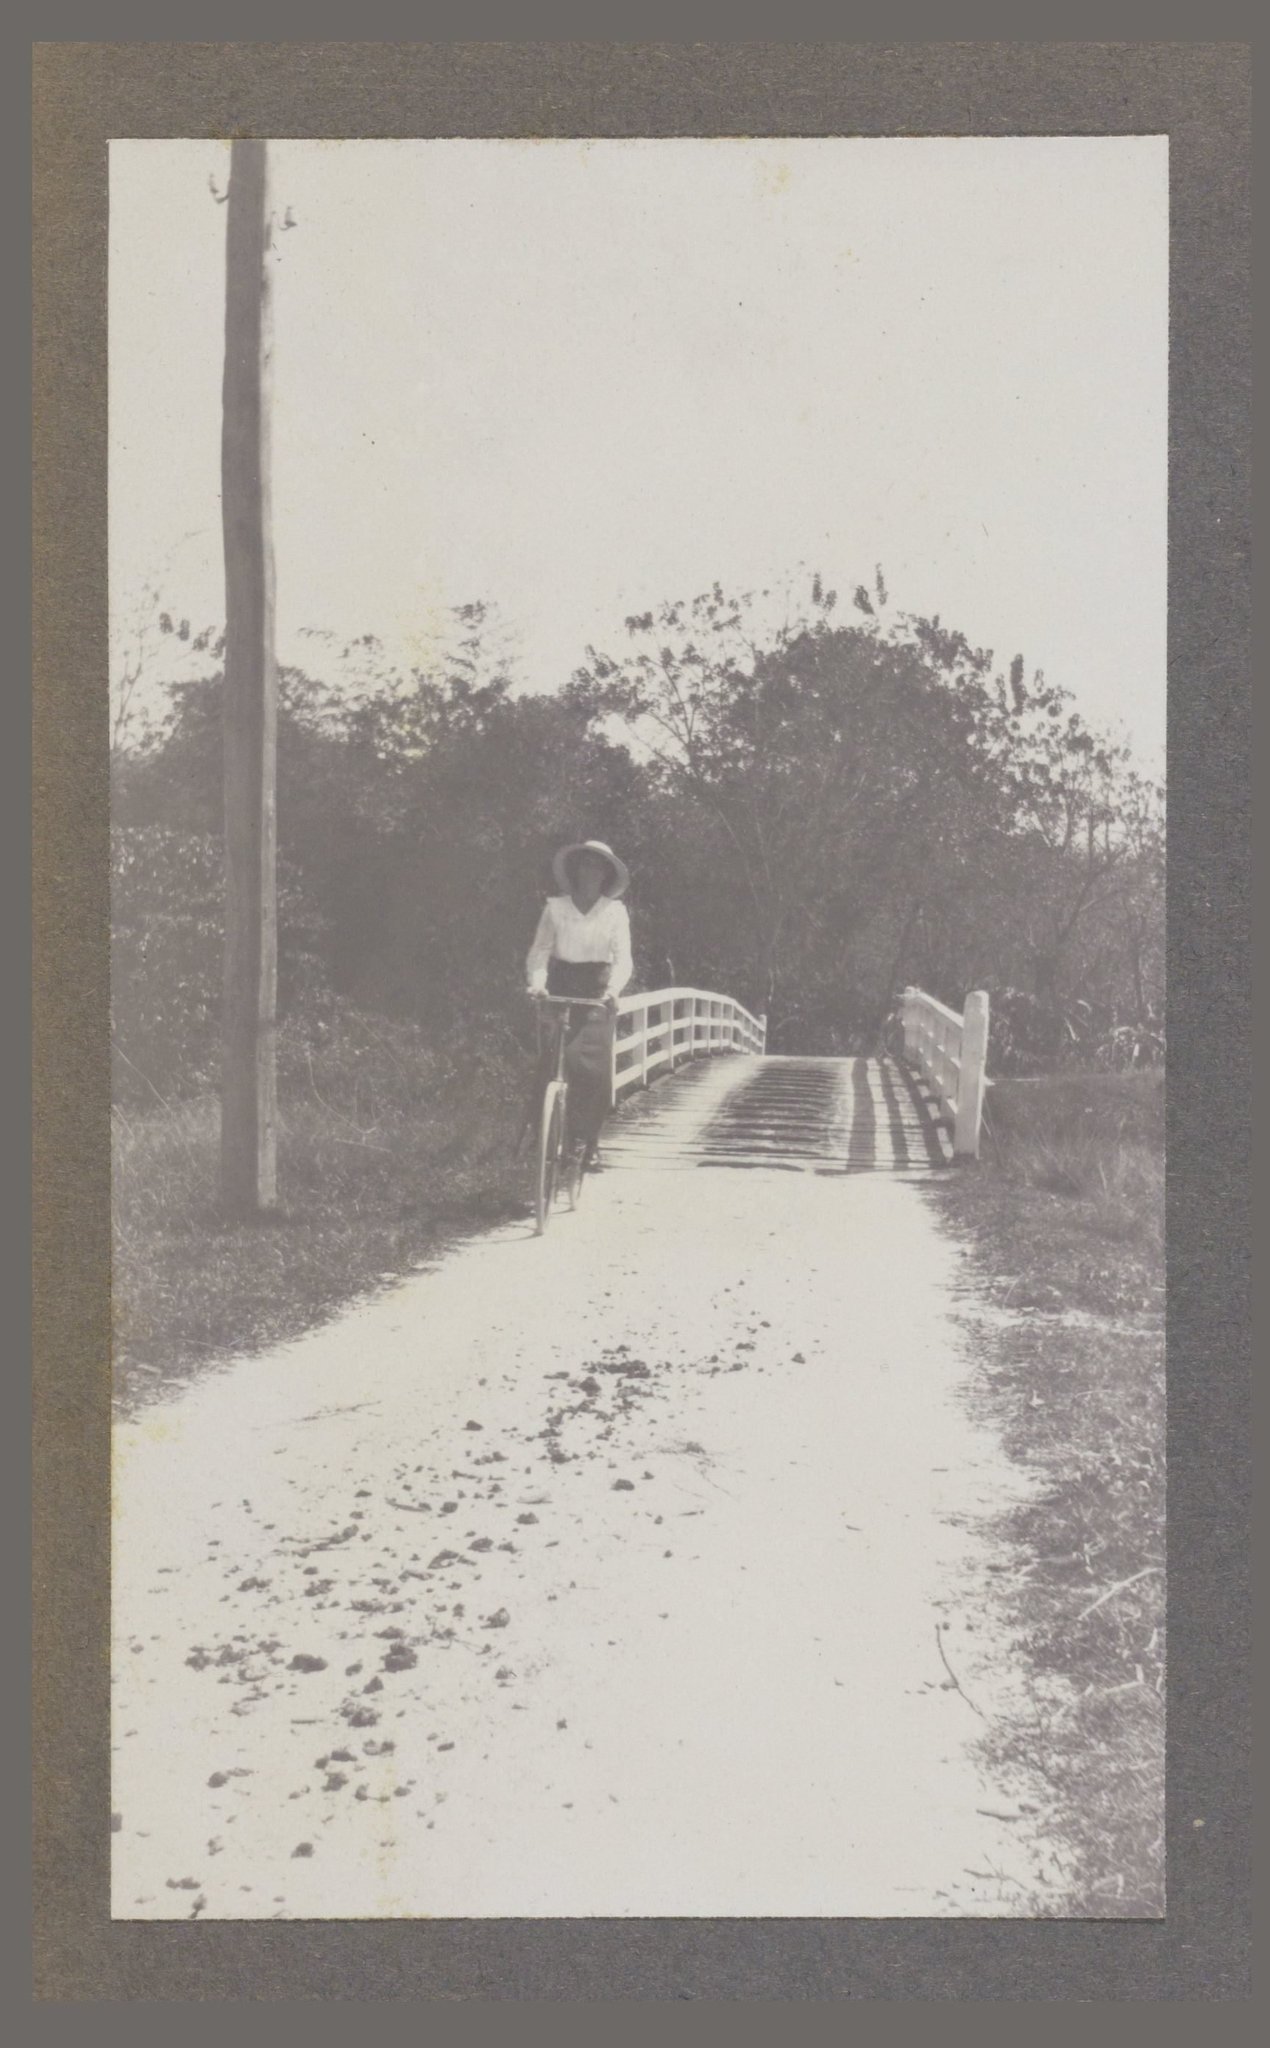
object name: photograph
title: Maria Gonggrijp op de fiets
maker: andries augustus boom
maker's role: amateurfotograaf, handelaar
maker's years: 1878-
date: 1911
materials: photographic support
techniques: photography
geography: suriname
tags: bicycle, suriname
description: Maria Gonggrijp rijdend op een fiets. Onderdeel van het fotoalbum over het leven van de familie Gonggrijp in Suriname rond 1912.